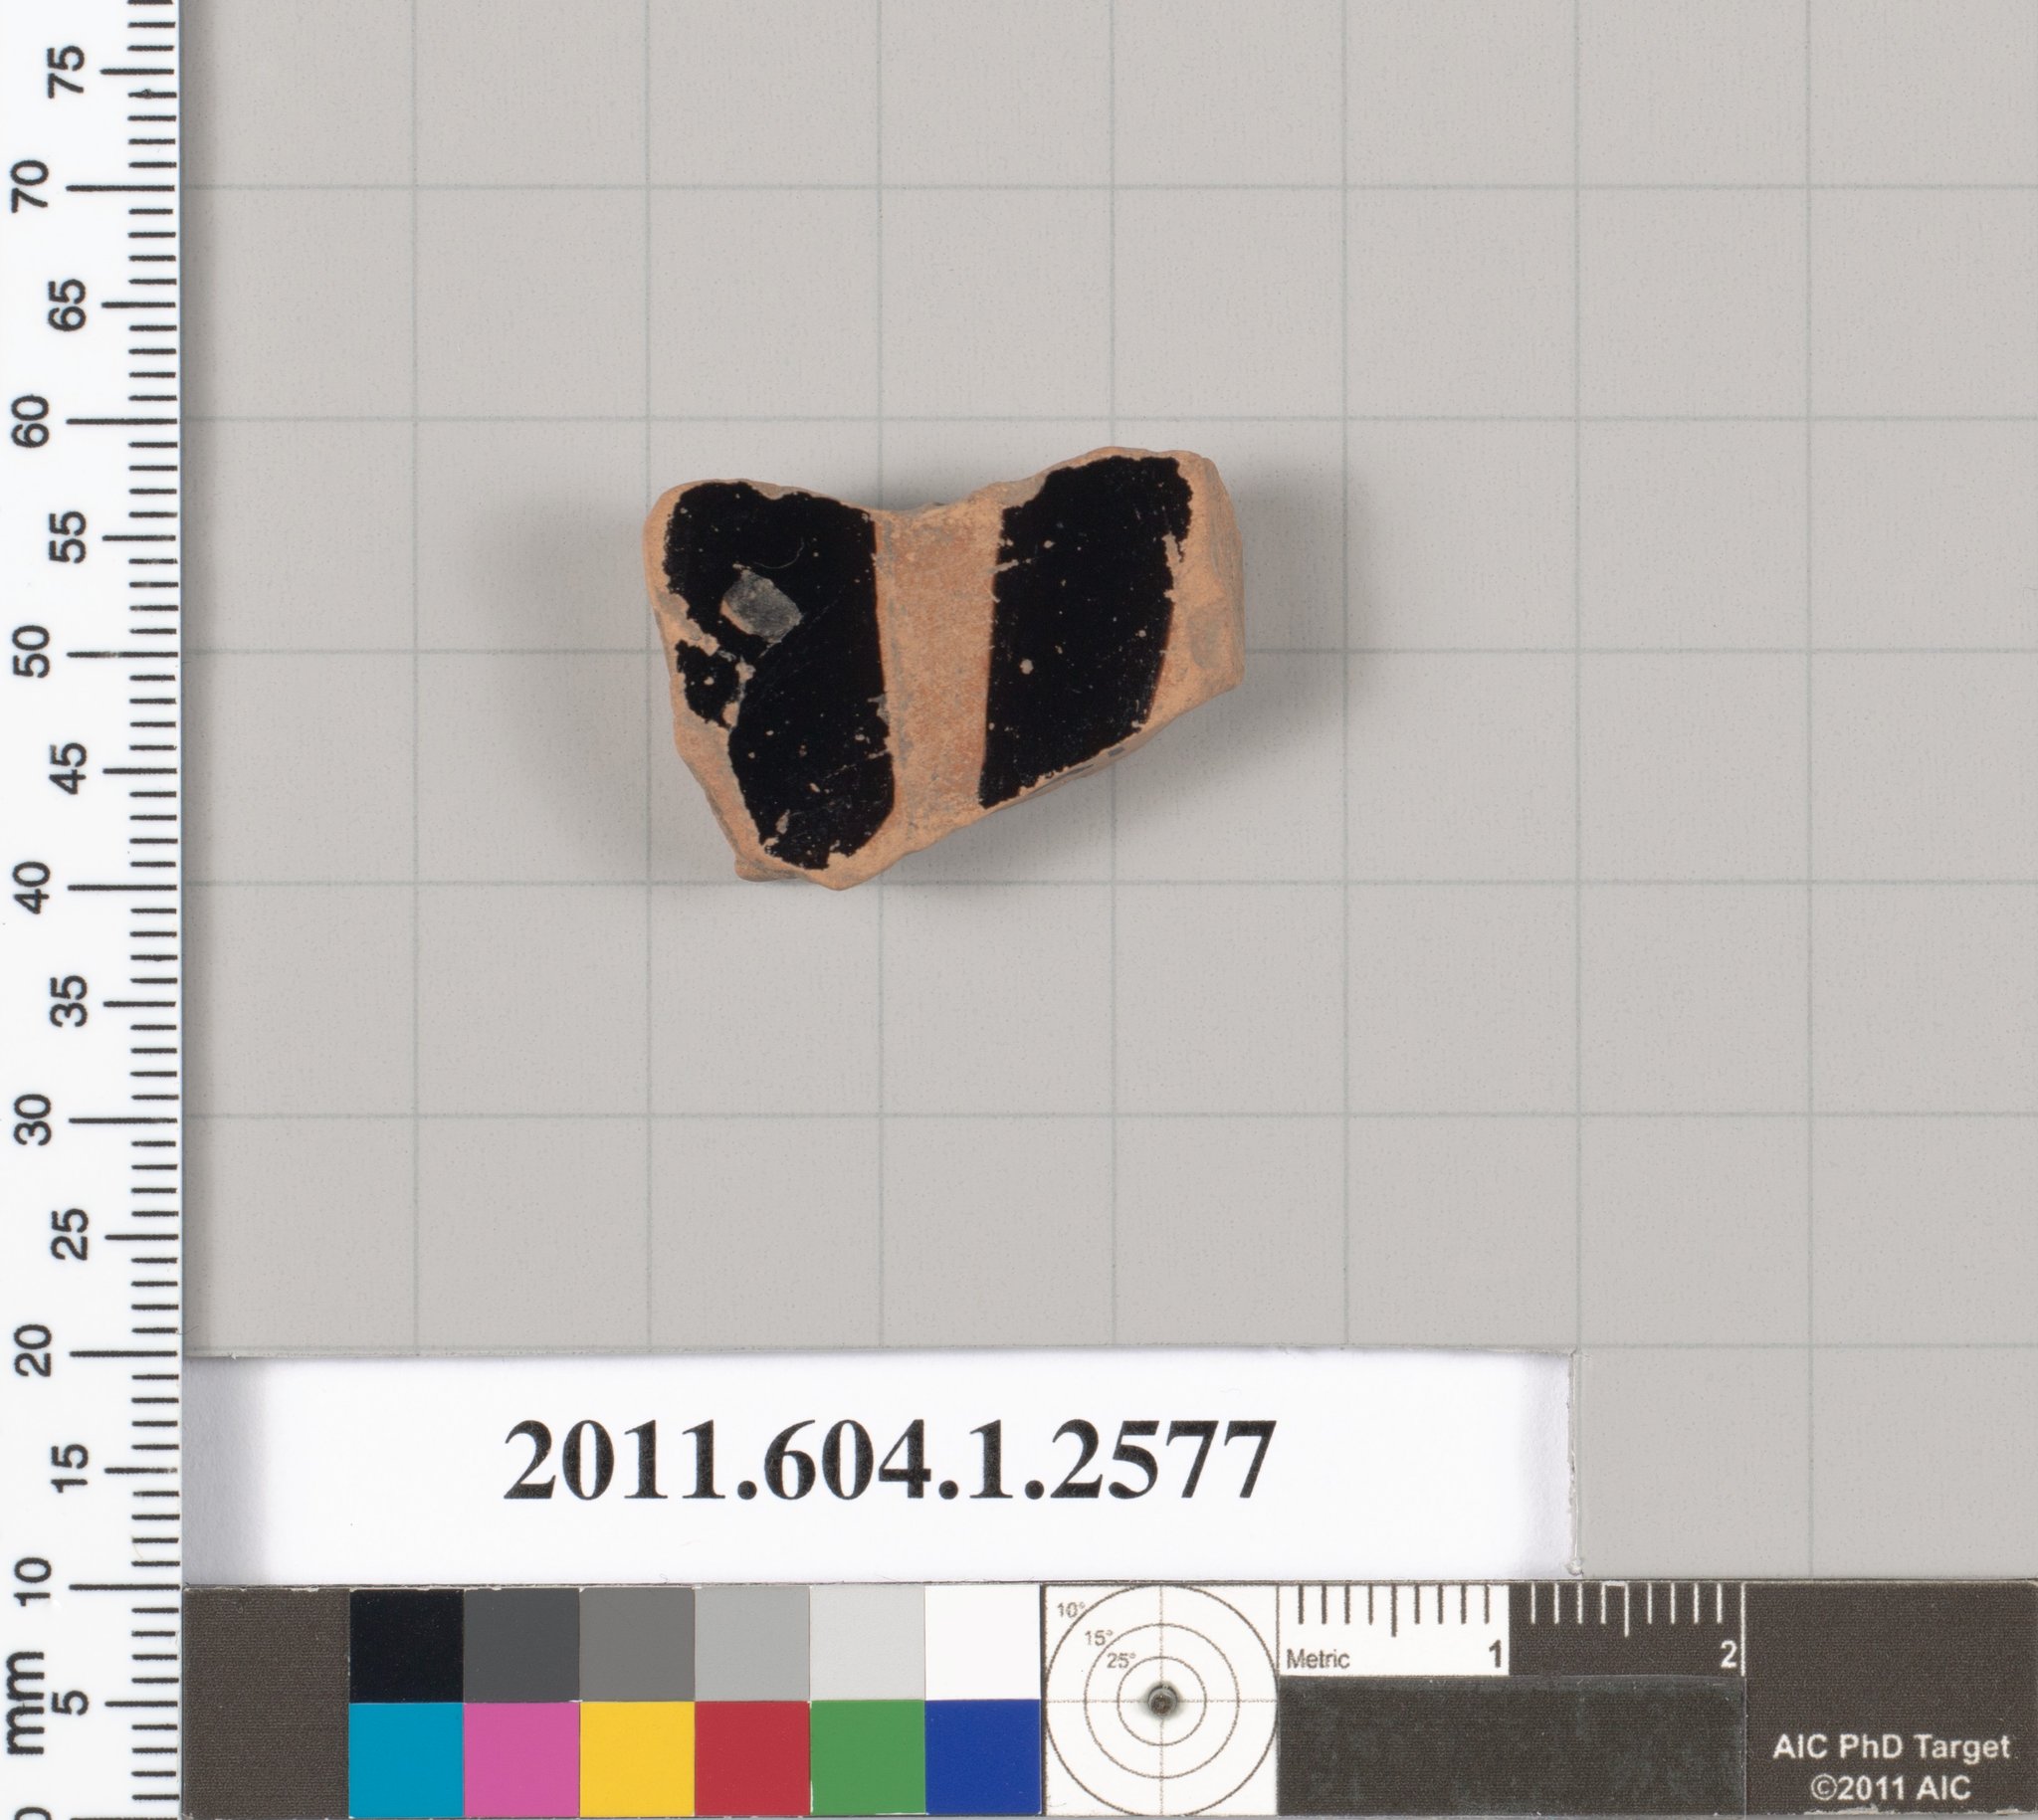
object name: kylix fragment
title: Terracotta fragment of a kylix (drinking cup)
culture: greek, attic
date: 490-480 BCE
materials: terracotta